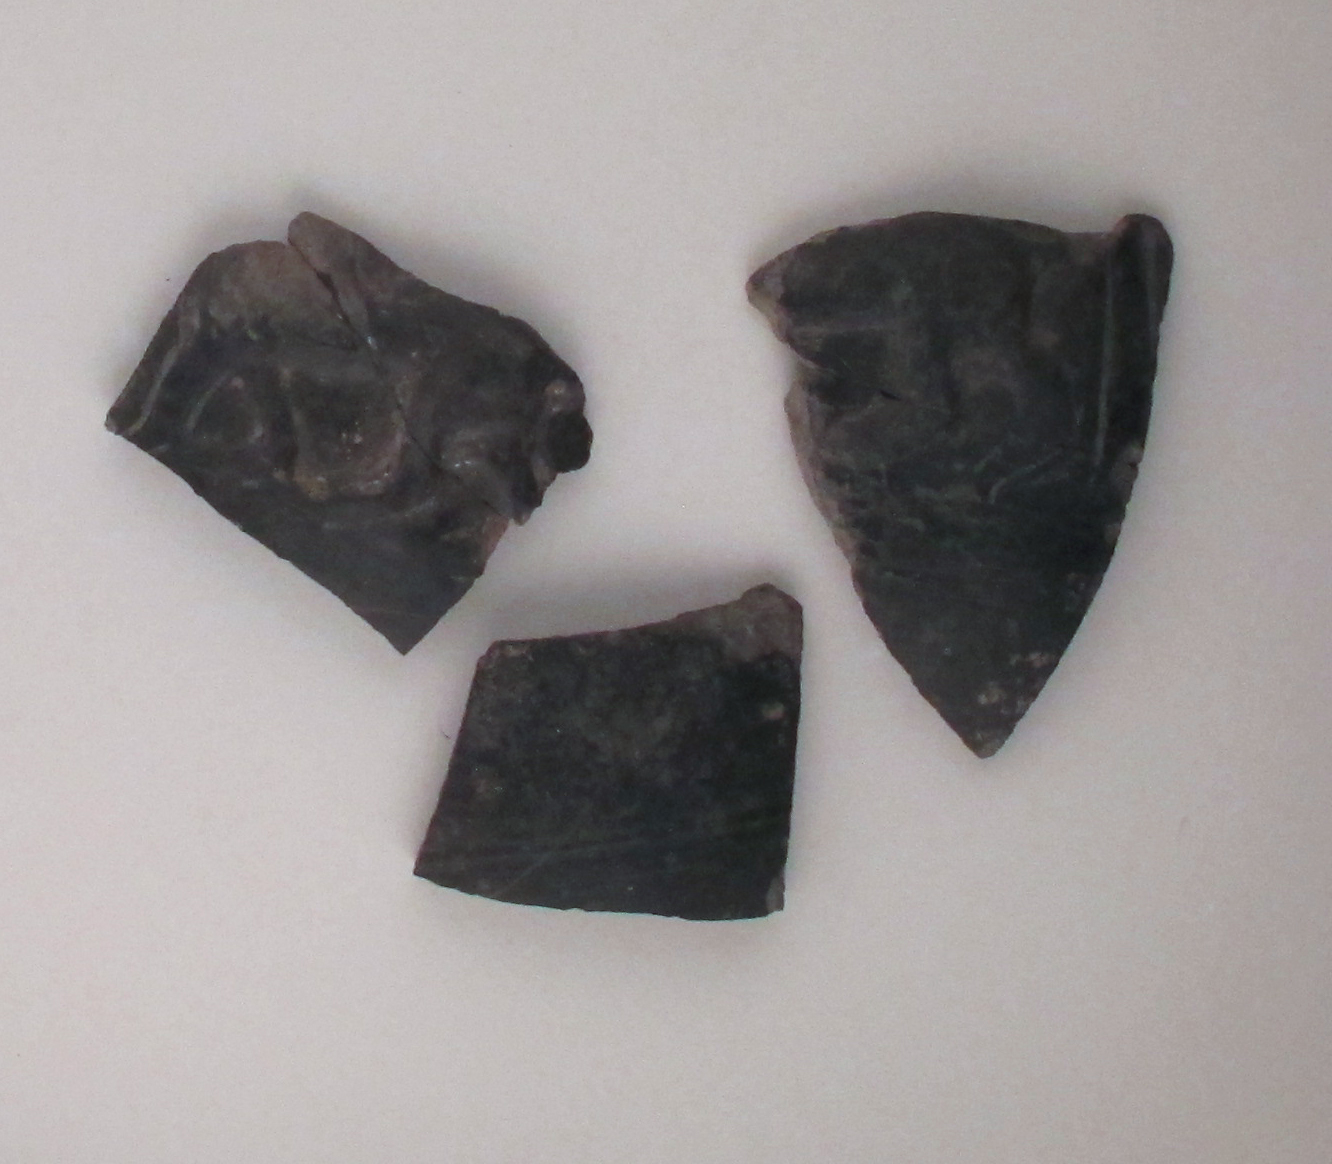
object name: vase fragment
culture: etruscan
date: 575-550 BCE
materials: terracotta